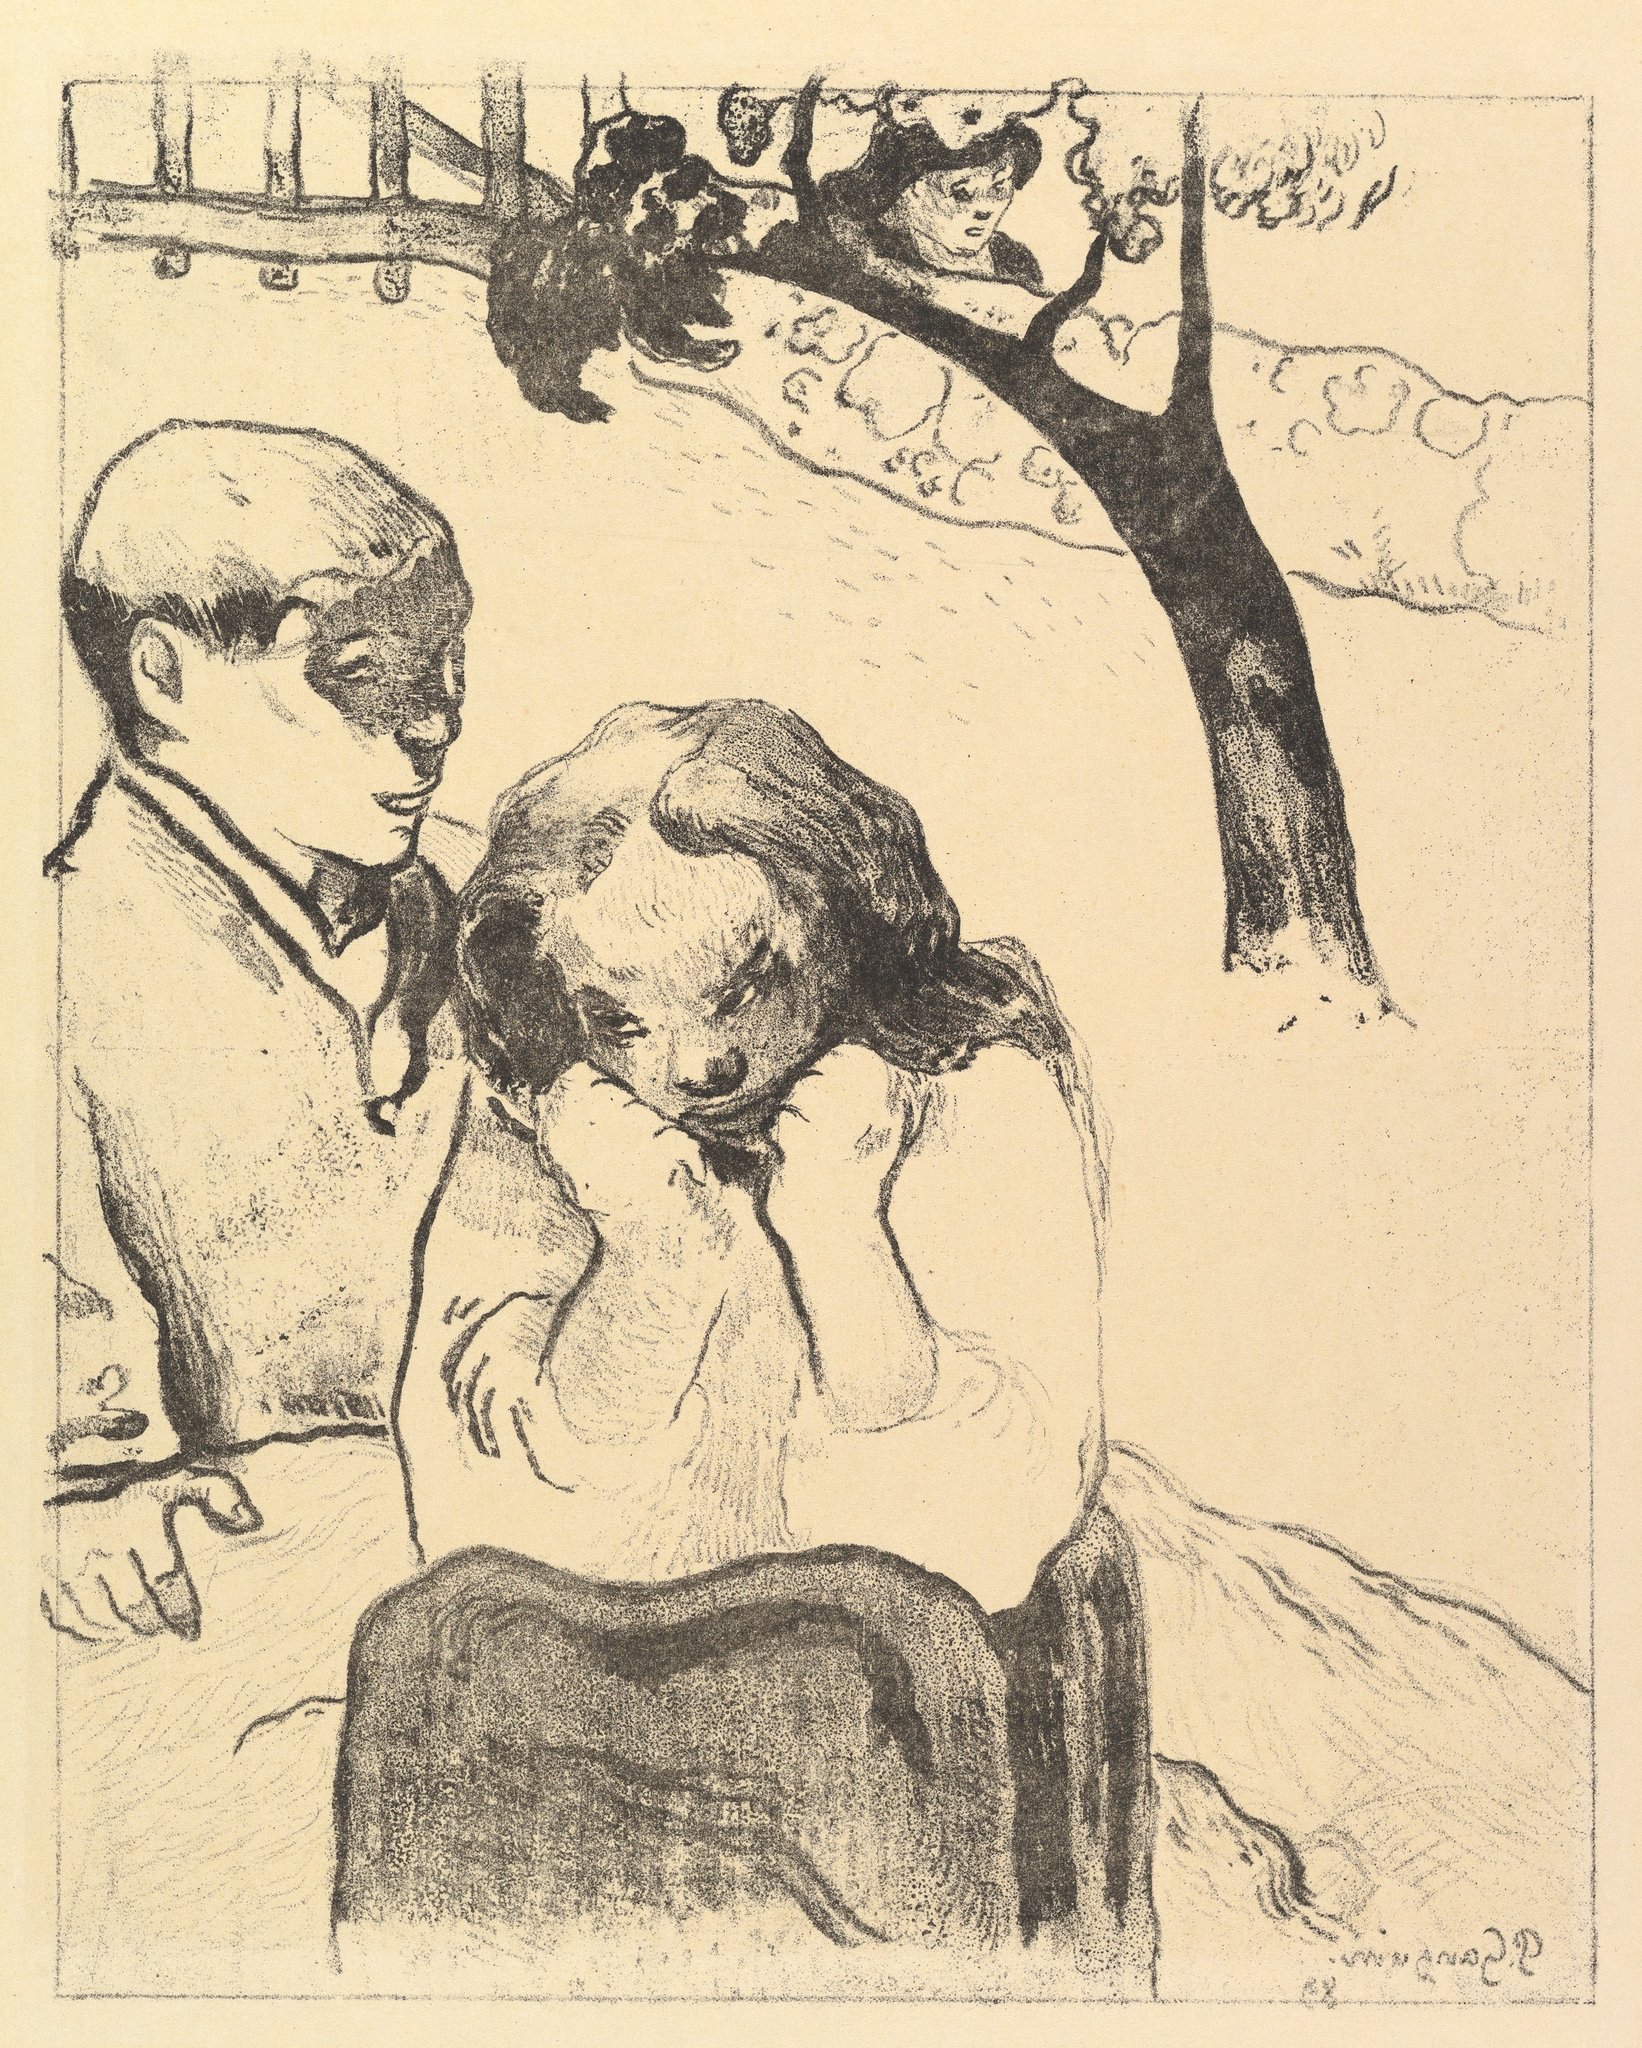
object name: print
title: Human Misery, from the Volpini Suite: Dessins lithographiques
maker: paul gauguin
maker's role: artist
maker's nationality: french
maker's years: 1848-1903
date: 1889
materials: paper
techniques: lithography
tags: faces,suffering,men,women,trees